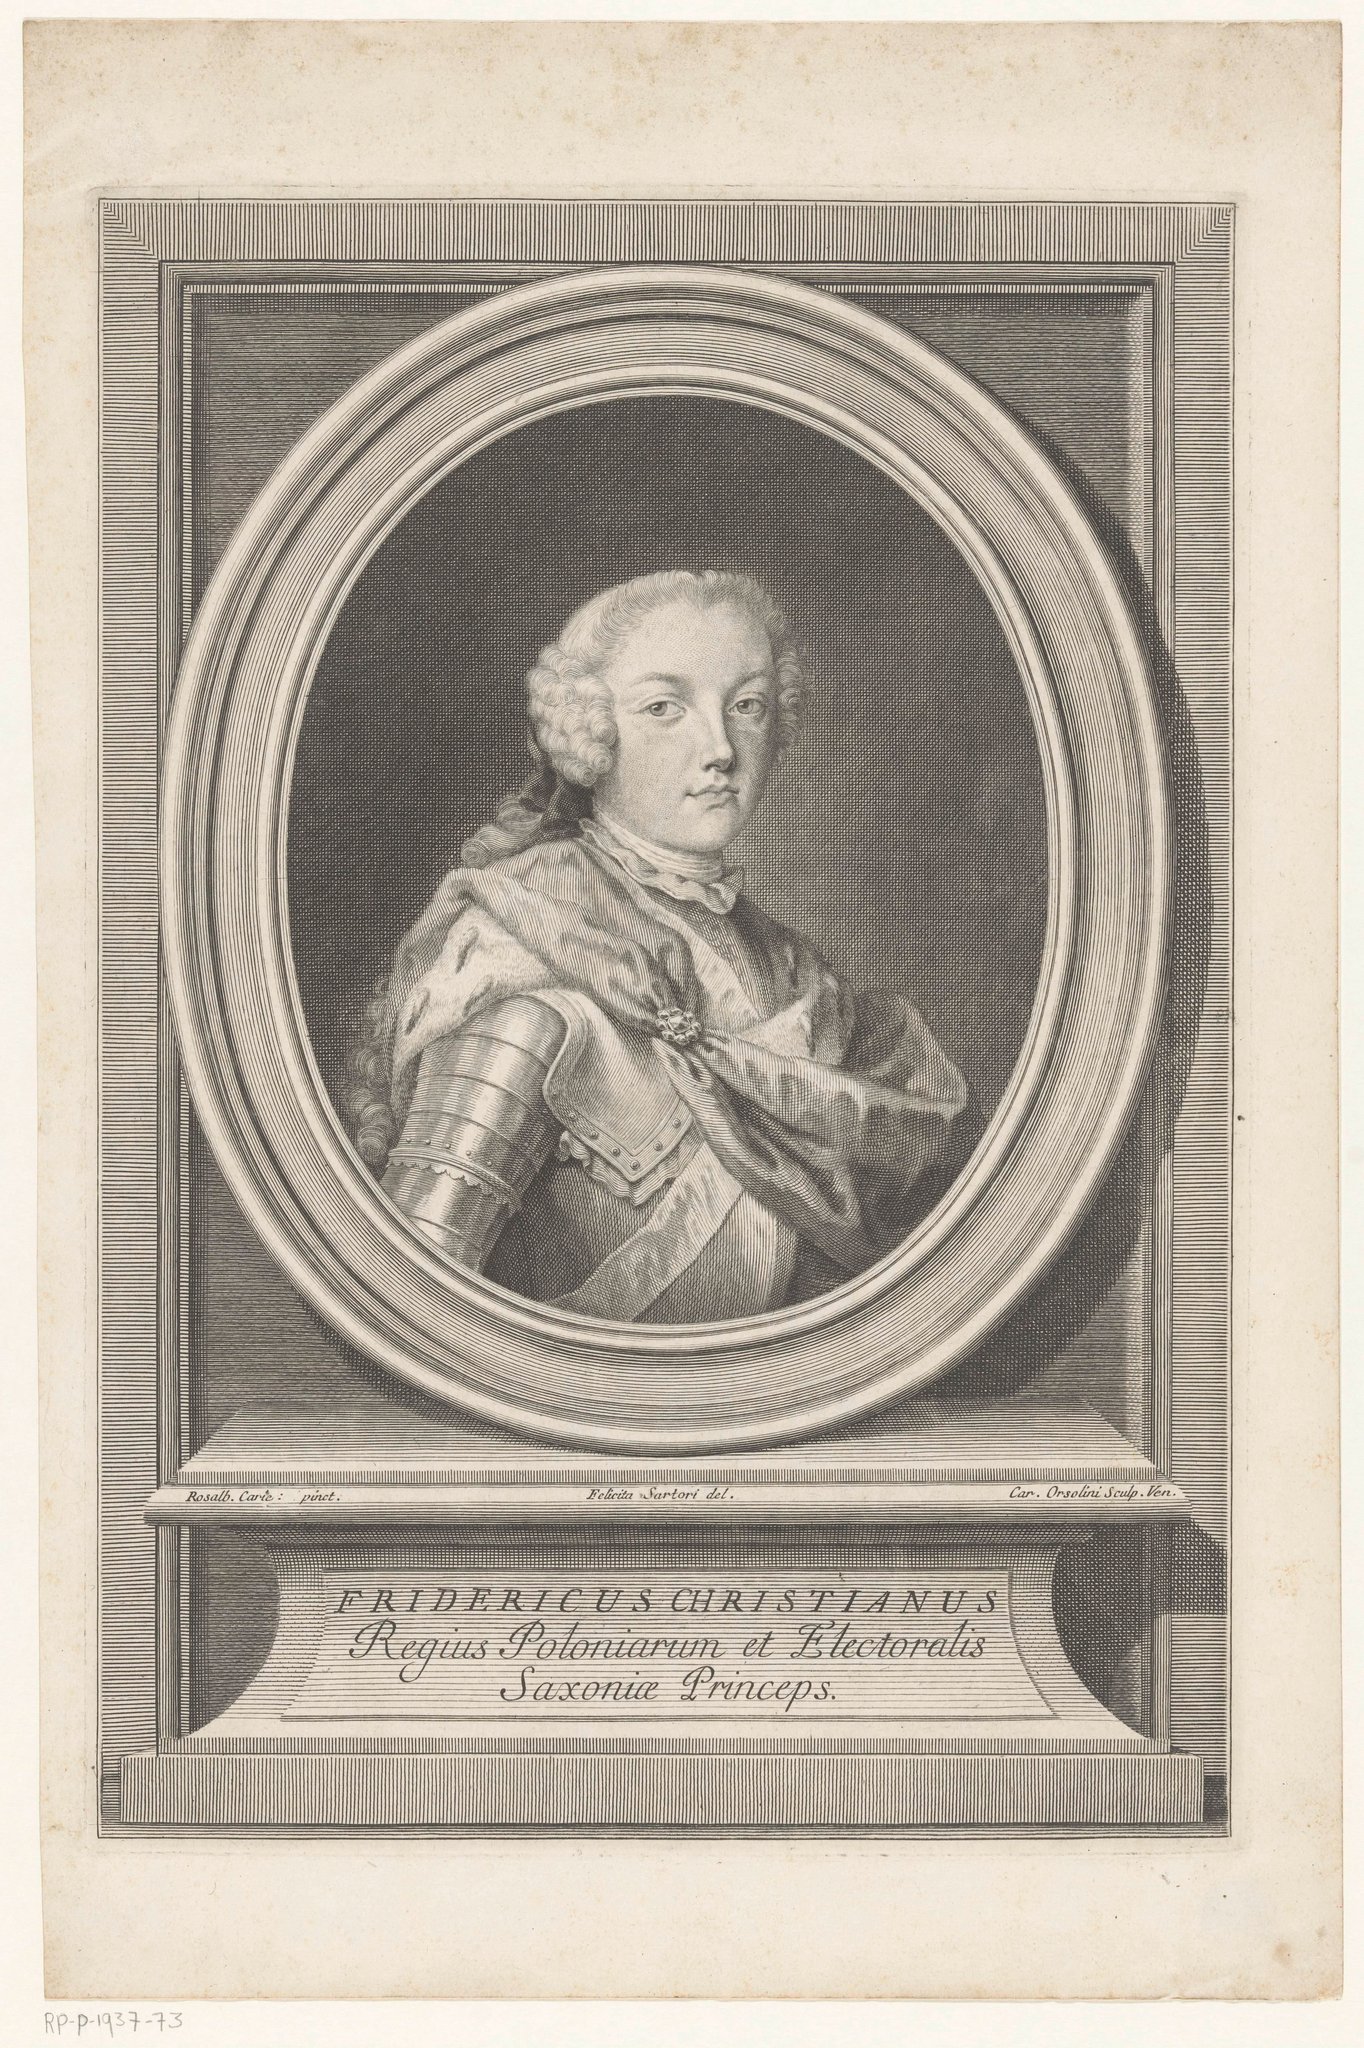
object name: print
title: Portret van Frederik Christiaan, keurvorst van Saksen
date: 1732-1780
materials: paper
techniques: engraving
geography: italy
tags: frederik christiaan keurvorst van saksen, historical persons, ruler, sovereign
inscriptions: collector's mark: Lugt 2228